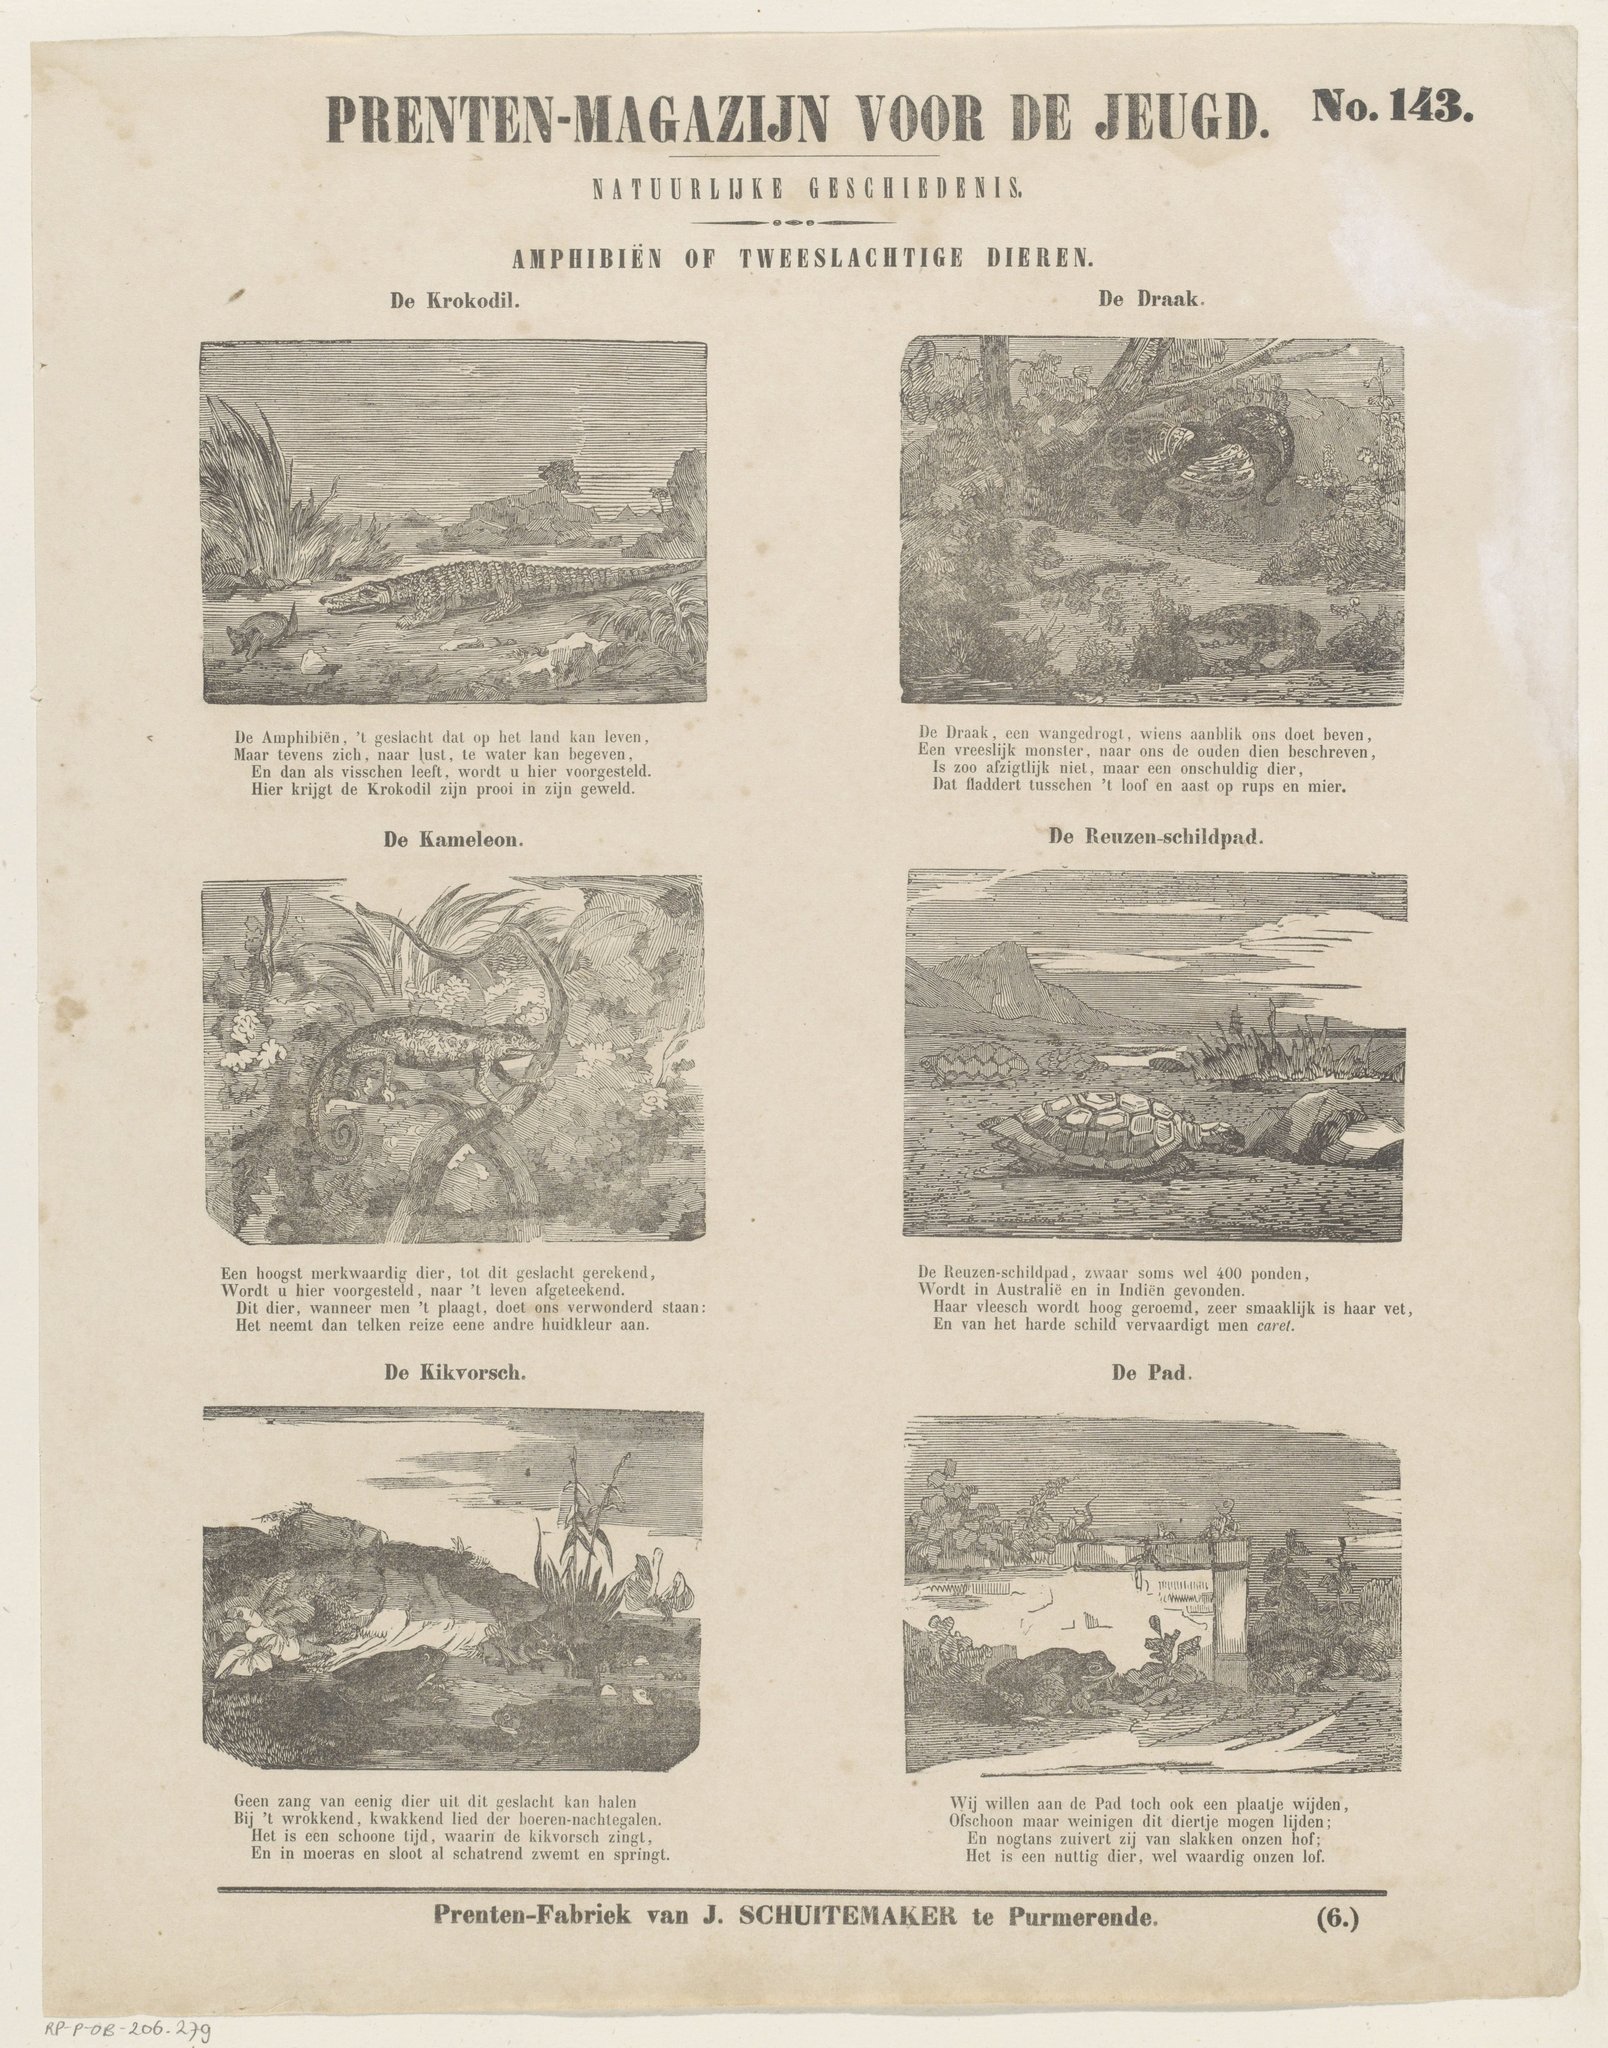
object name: popular print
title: Prenten-magazijn voor de jeugd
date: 1850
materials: paper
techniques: letterpress printing, engraving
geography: netherlands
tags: tailless amphibians: frog, tortoises, turtles, tailless amphibians: toad, crocodiles: crocodile, amphibians, lizards: chameleon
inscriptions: collector's mark: Lugt 2760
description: Na voltooiing van de acht jaargangen van de reeks 'Prenten-magazijn voor de jeugd' in 1850 heeft Jan Schuitemaker al deze prenten heruitgegeven en omgenummerd als nr. 1 t/m 192. De oorspronkelijke jaargang wordt telkens nog vermeld rechtsonder op de prent. Binnen de jaargangen zijn prenten van hetzelfde thema in clusters van vier achter elkaar gezet.